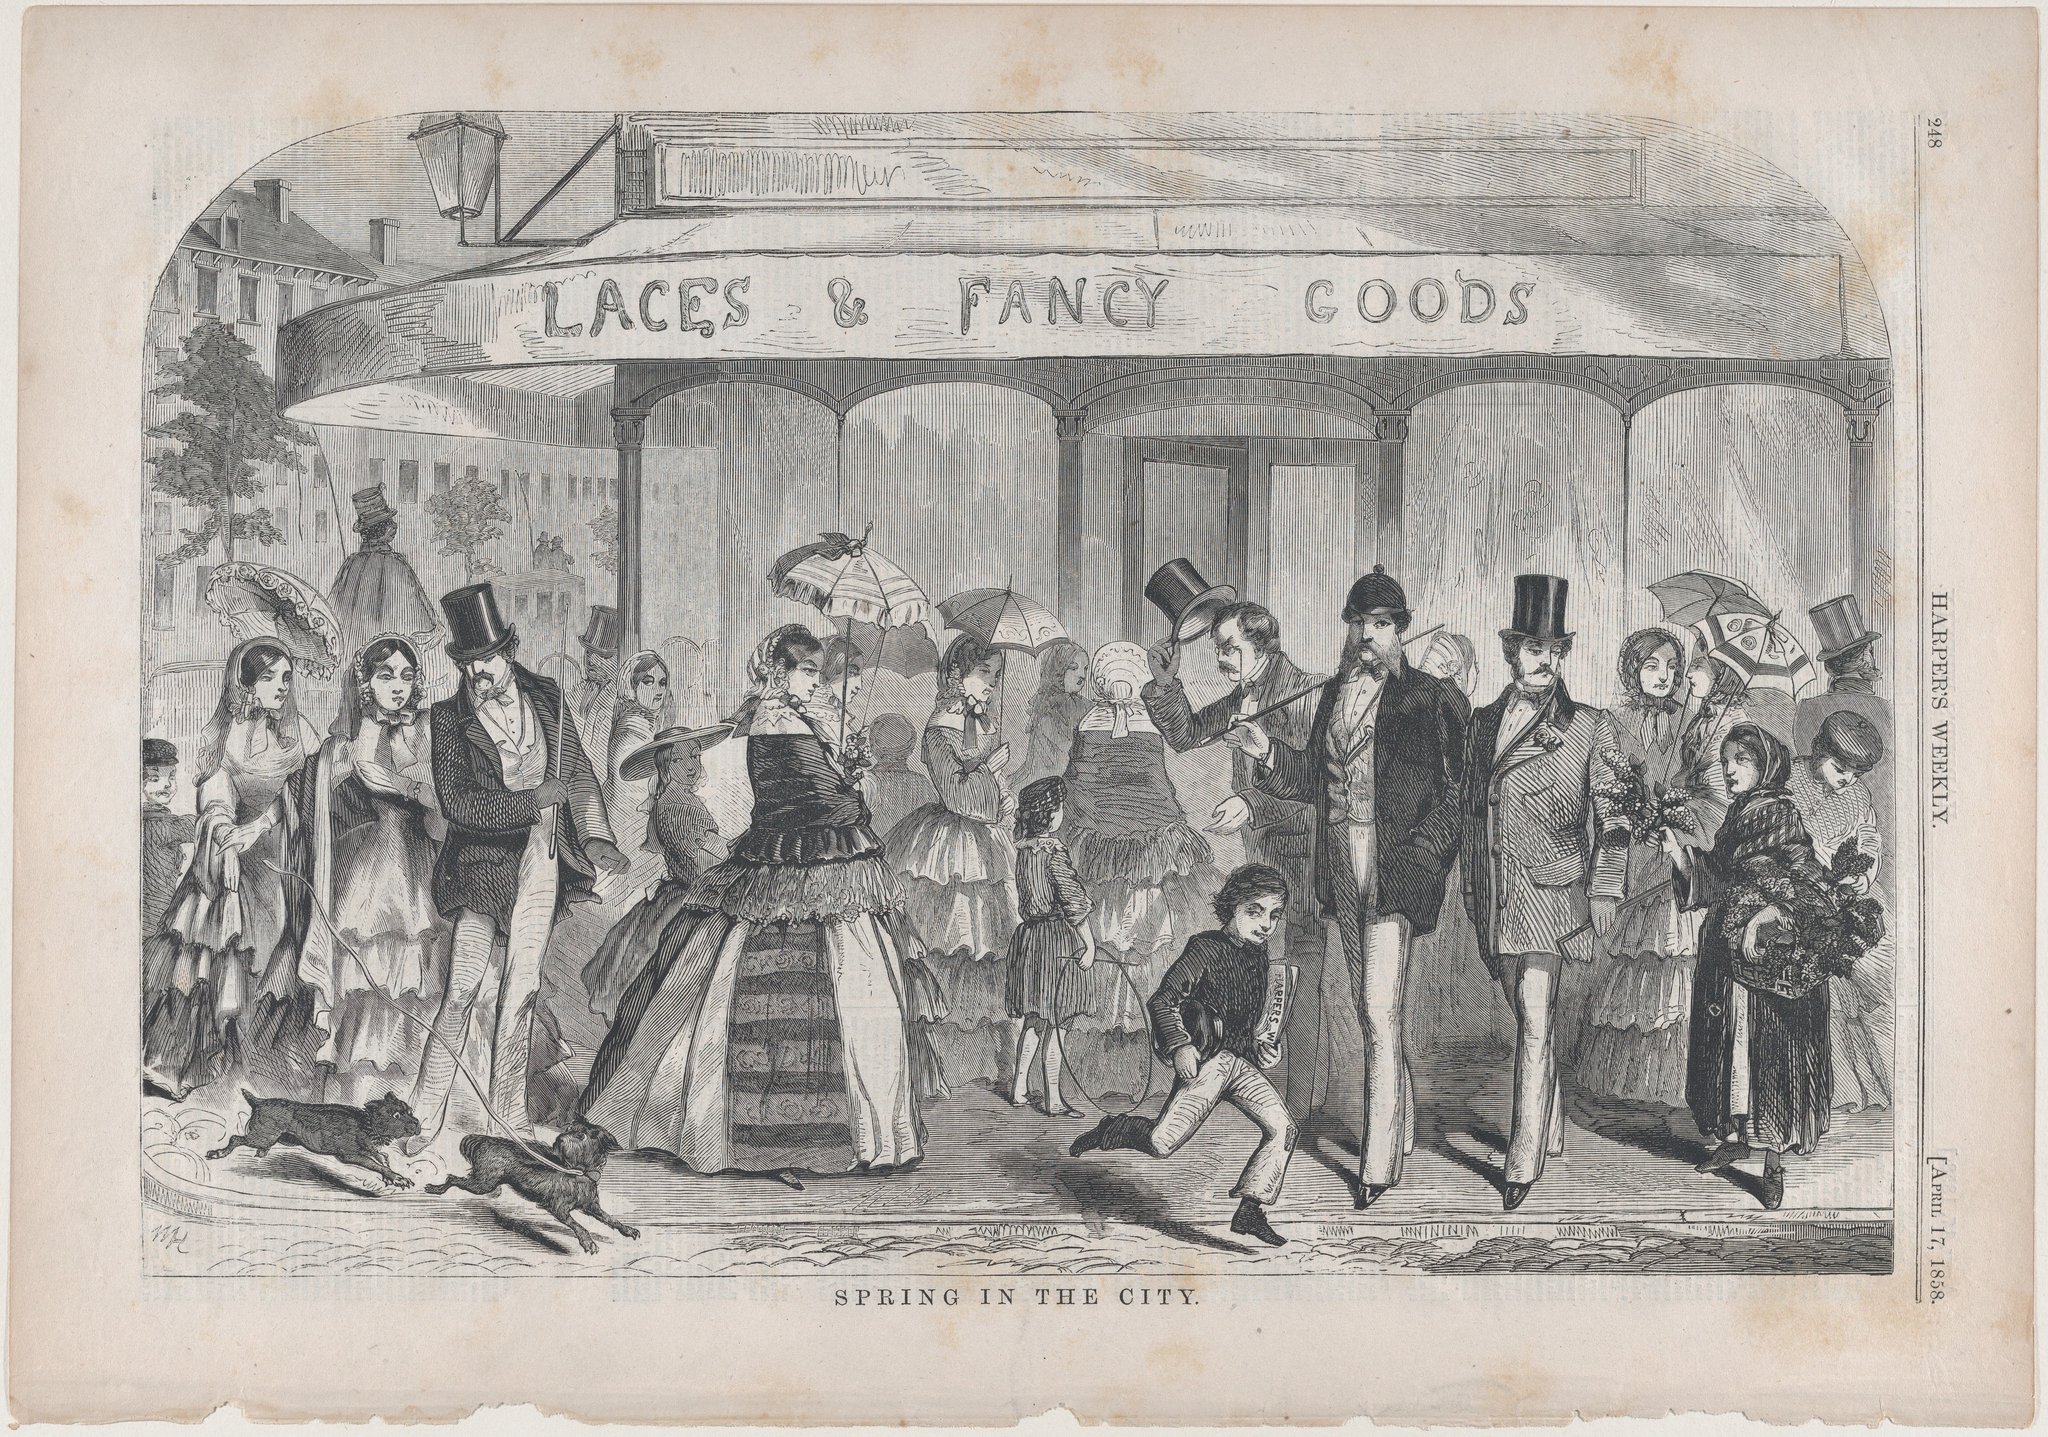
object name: print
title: Spring in the City (from "Harper's Weekly," Vol. II)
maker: winslow homer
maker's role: artist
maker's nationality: american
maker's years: 1836-1910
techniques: engraving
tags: children,men,women,spring